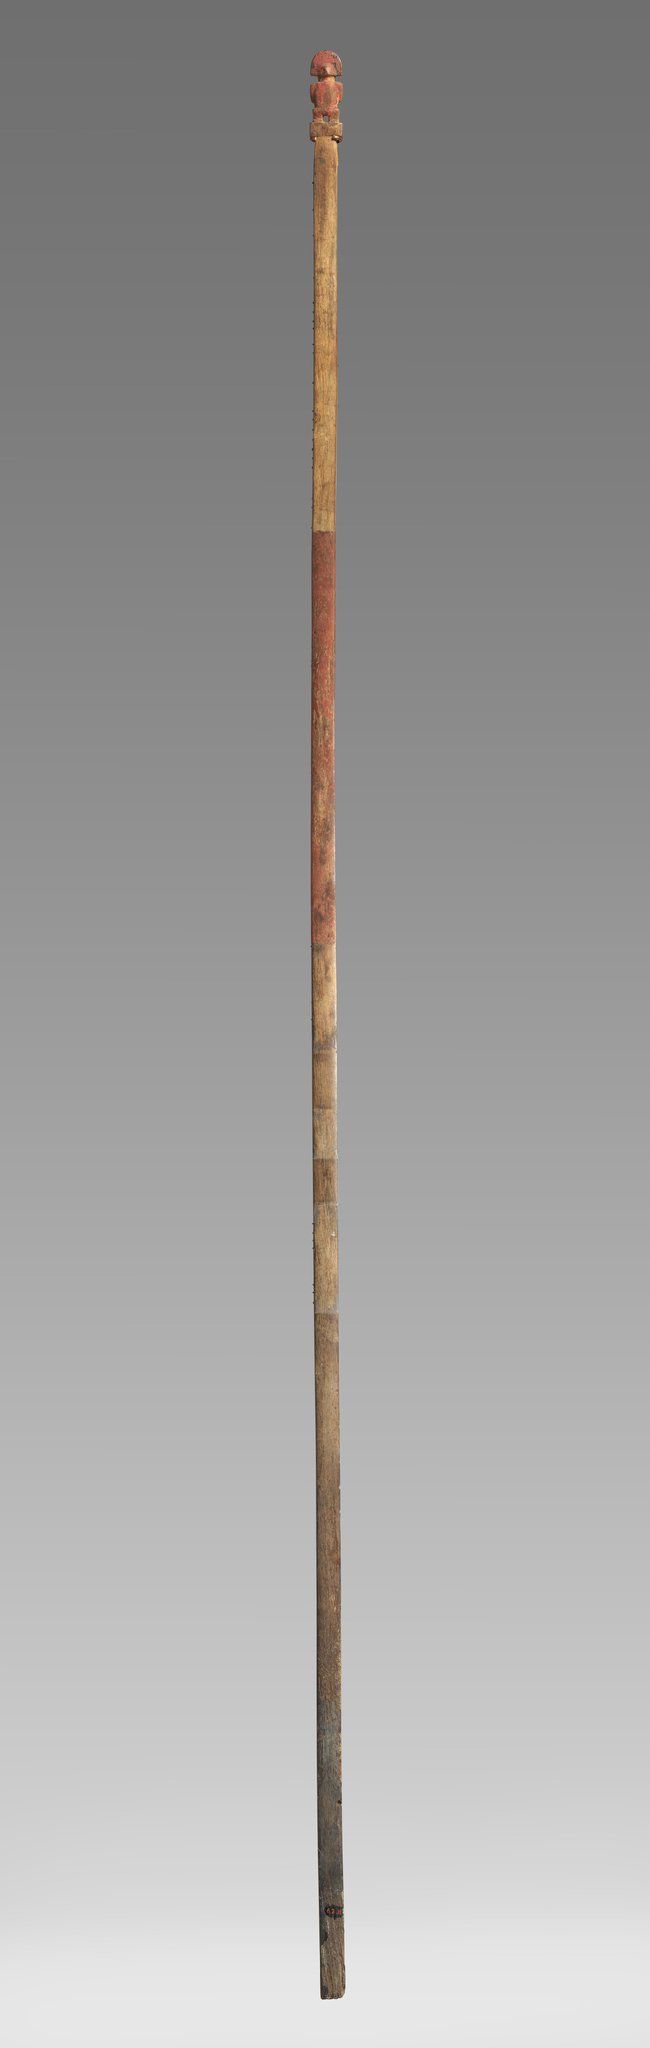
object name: tomb staff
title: Funerary staff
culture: inca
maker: inca artist(s)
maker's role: artist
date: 1400-1535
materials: copper, metal, paint, wood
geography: peru